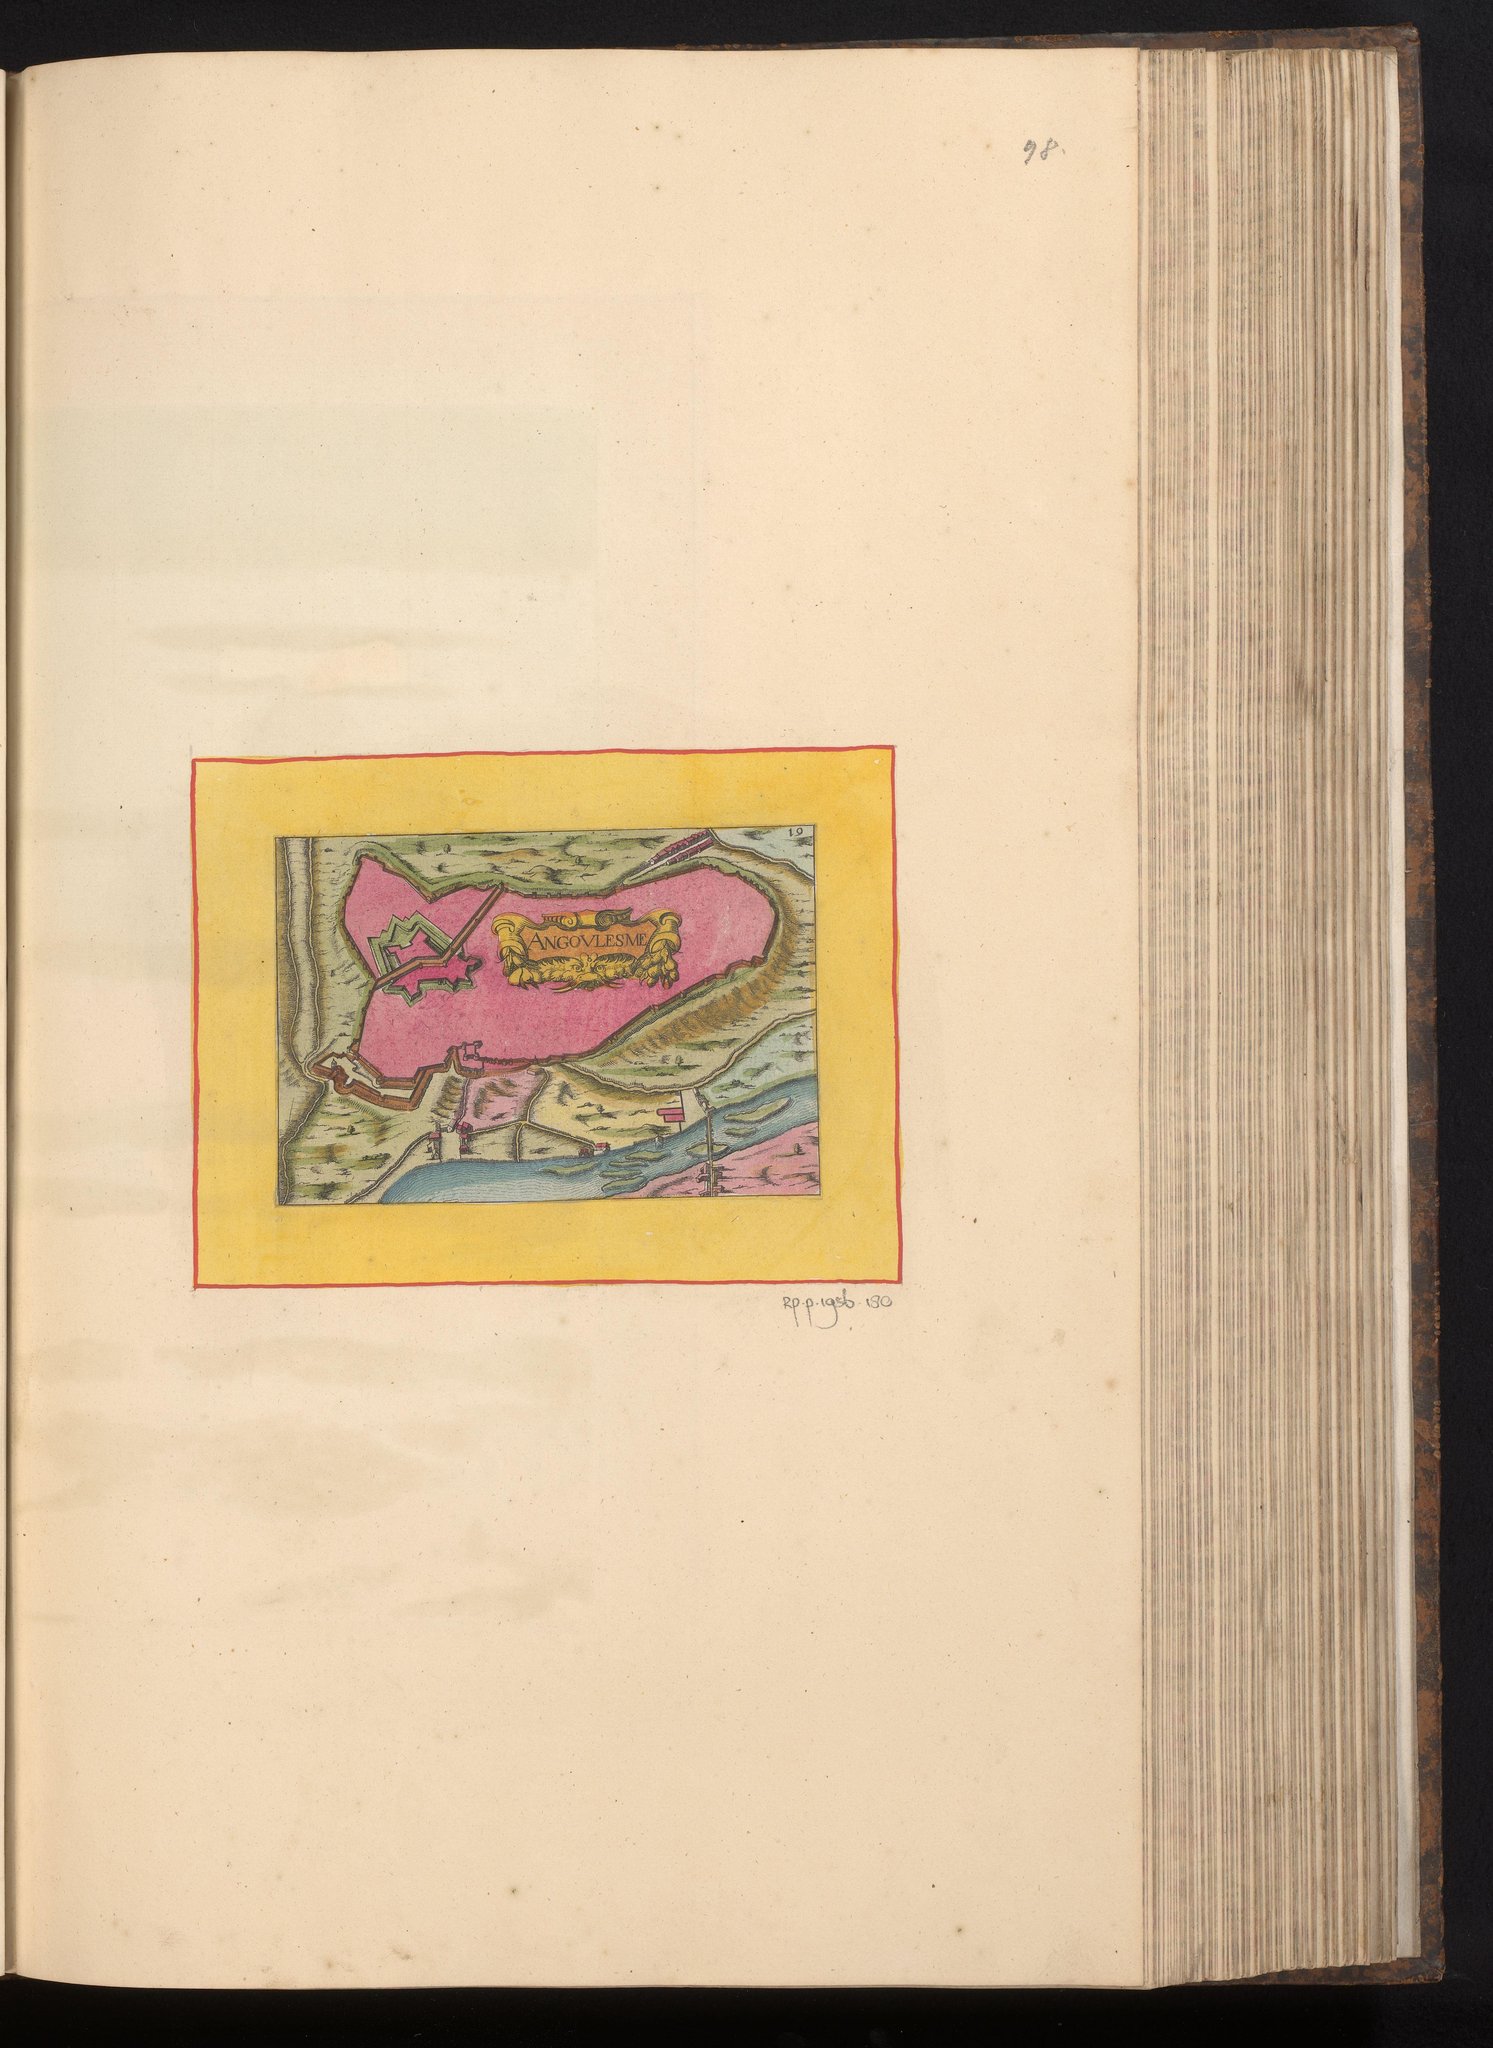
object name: print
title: Vestingplattegrond van Angoulême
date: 1638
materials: paper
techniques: engraving, etching, hand coloring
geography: paris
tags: maps of cities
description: Prent uit: Tassin, Christophe. Les plans et profils de toutes les principales villes et lieux considérables de France (...). Parijs: Michel van Lochom, 1638, prent nummer 19 in het deel 'Poictou'.